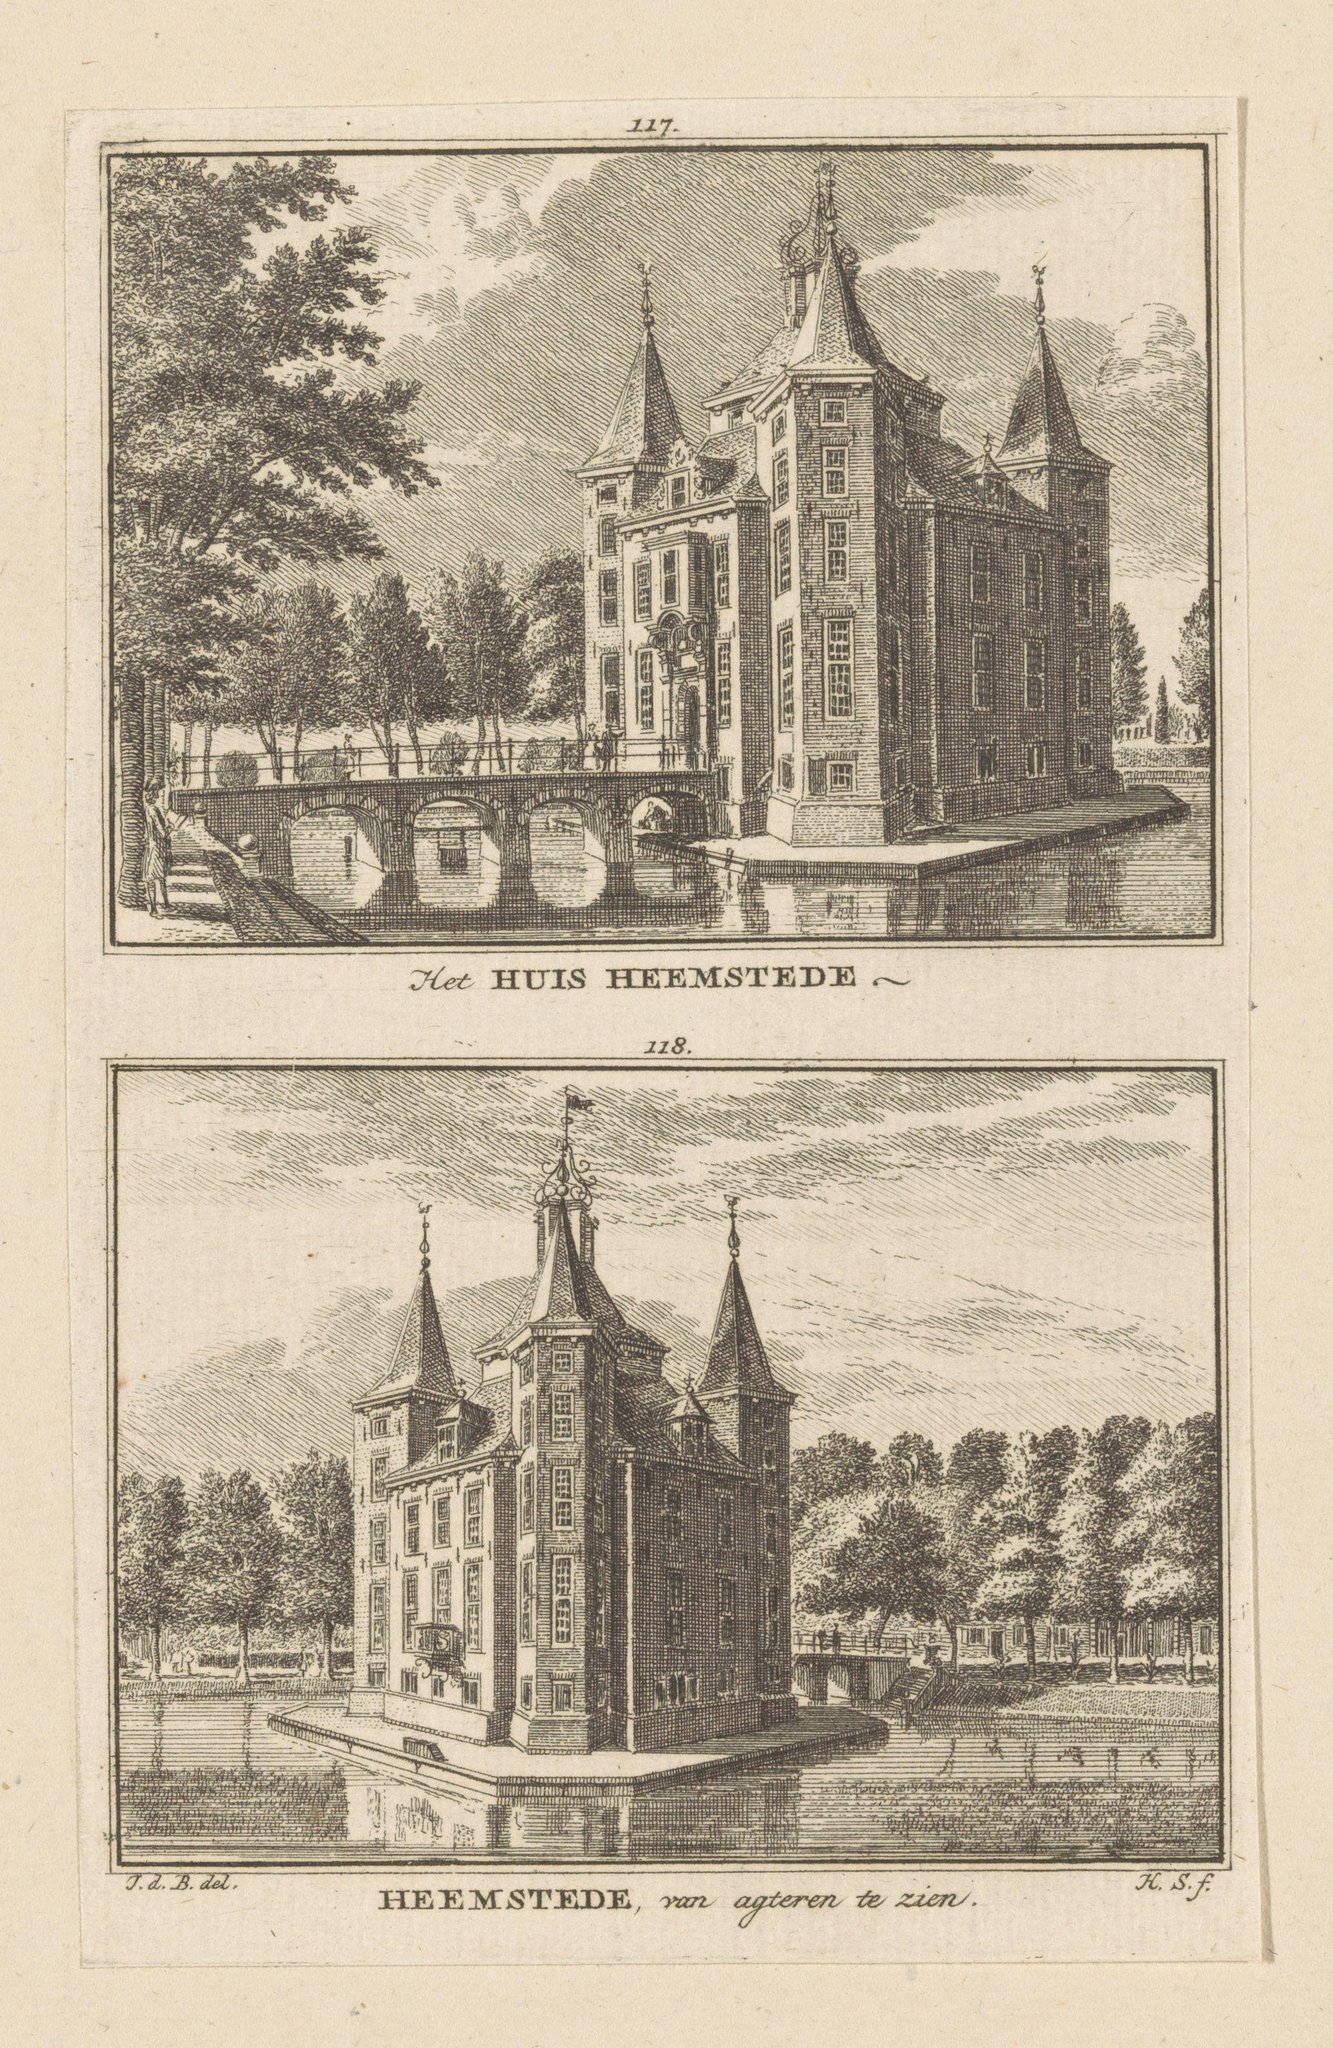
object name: book illustration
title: Twee gezichten op Kasteel Heemstede te Houten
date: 1773-1792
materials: paper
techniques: engraving, etching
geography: haarlem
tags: castle, bridge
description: Prent ook gebruikt in: Het verheerlykt Nederland of kabinet van hedendaagsche gezigten van steden, dorpen (…). 9 delen. Amsterdam: Isaak Tirion en weduwe Isaak Tirion, 1745-1774, dl. 7, 8 of 9 (weduwe Isaak Tirion, 1773-1774), ill. 117 en 118. Of in: Nederlandsche tafereelen; of eene keurige verzameling van negen honderd fraaije gezigten van steden, dorpen, sloten, oudheden (….). 9 delen. Amsterdam: Jan de Groot, 1792, dl. 7, 8 of 9, ill. 117 en 118. Uit welke druk het huidige exemplaar precies komt is niet na te gaan.